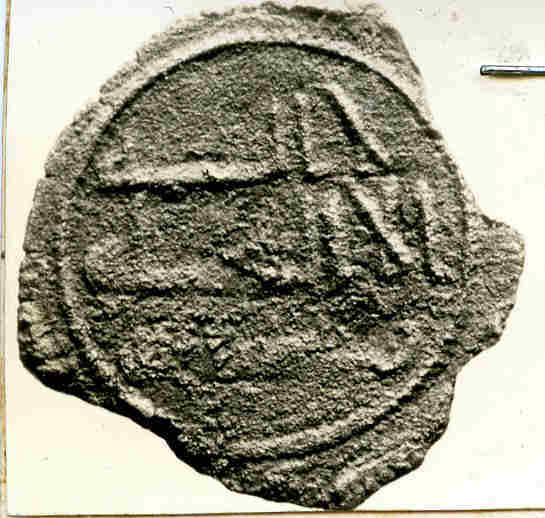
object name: coin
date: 770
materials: copper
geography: iran